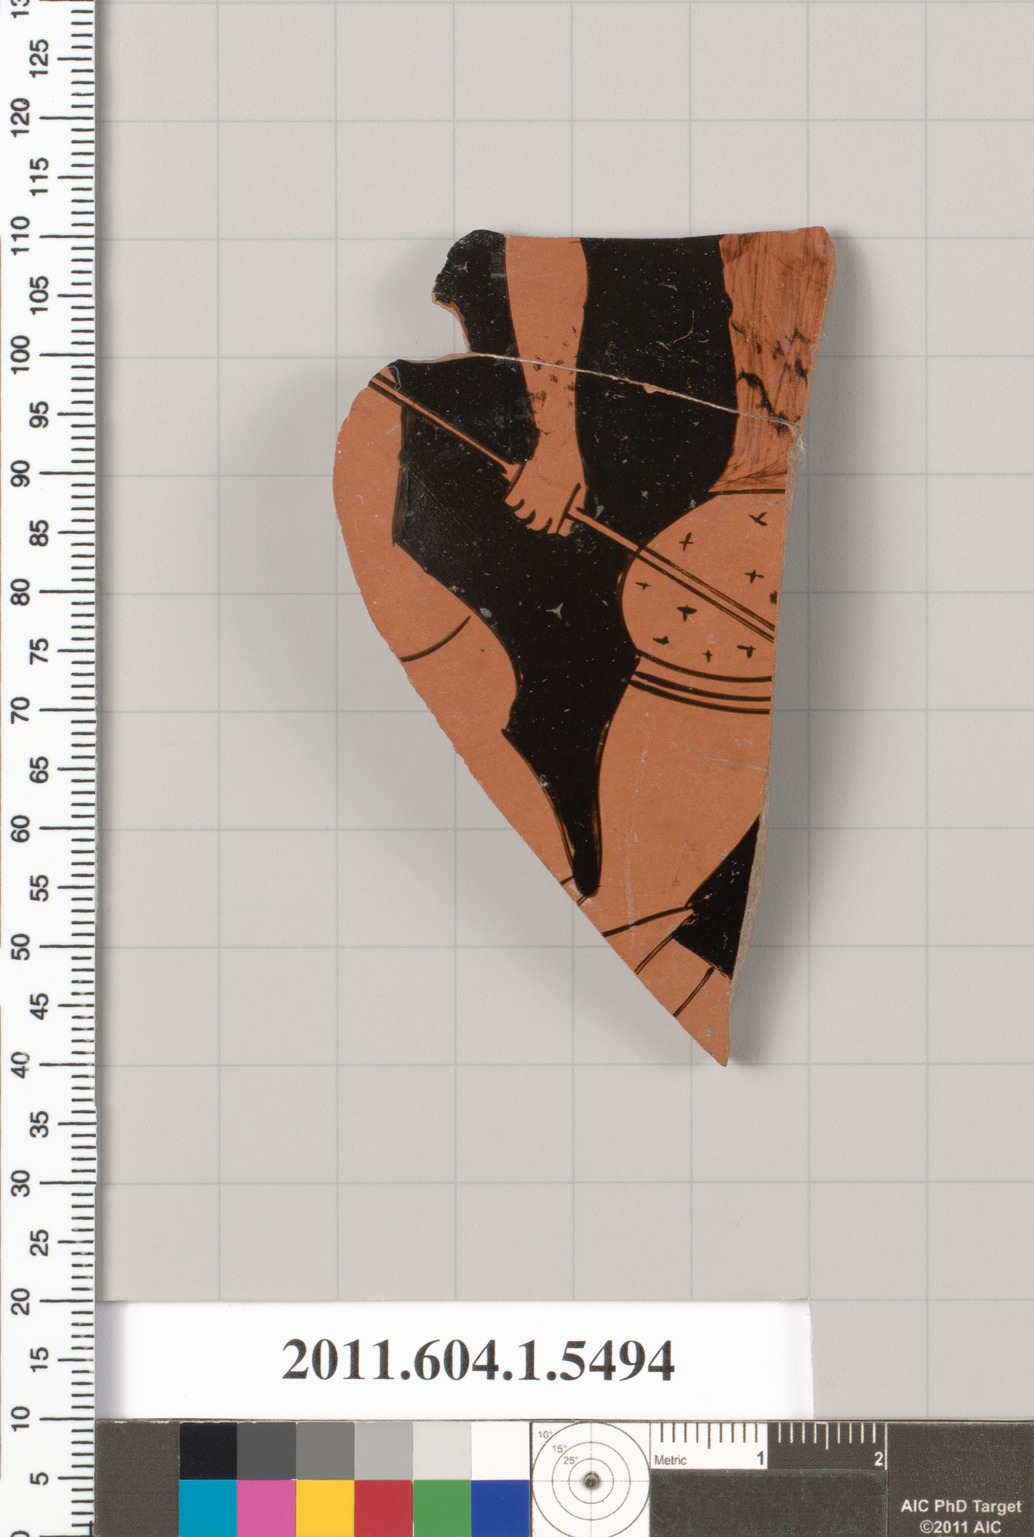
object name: kylix fragment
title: Terracotta fragment of a kylix (drinking cup)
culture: greek, attic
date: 530-520 BCE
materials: terracotta